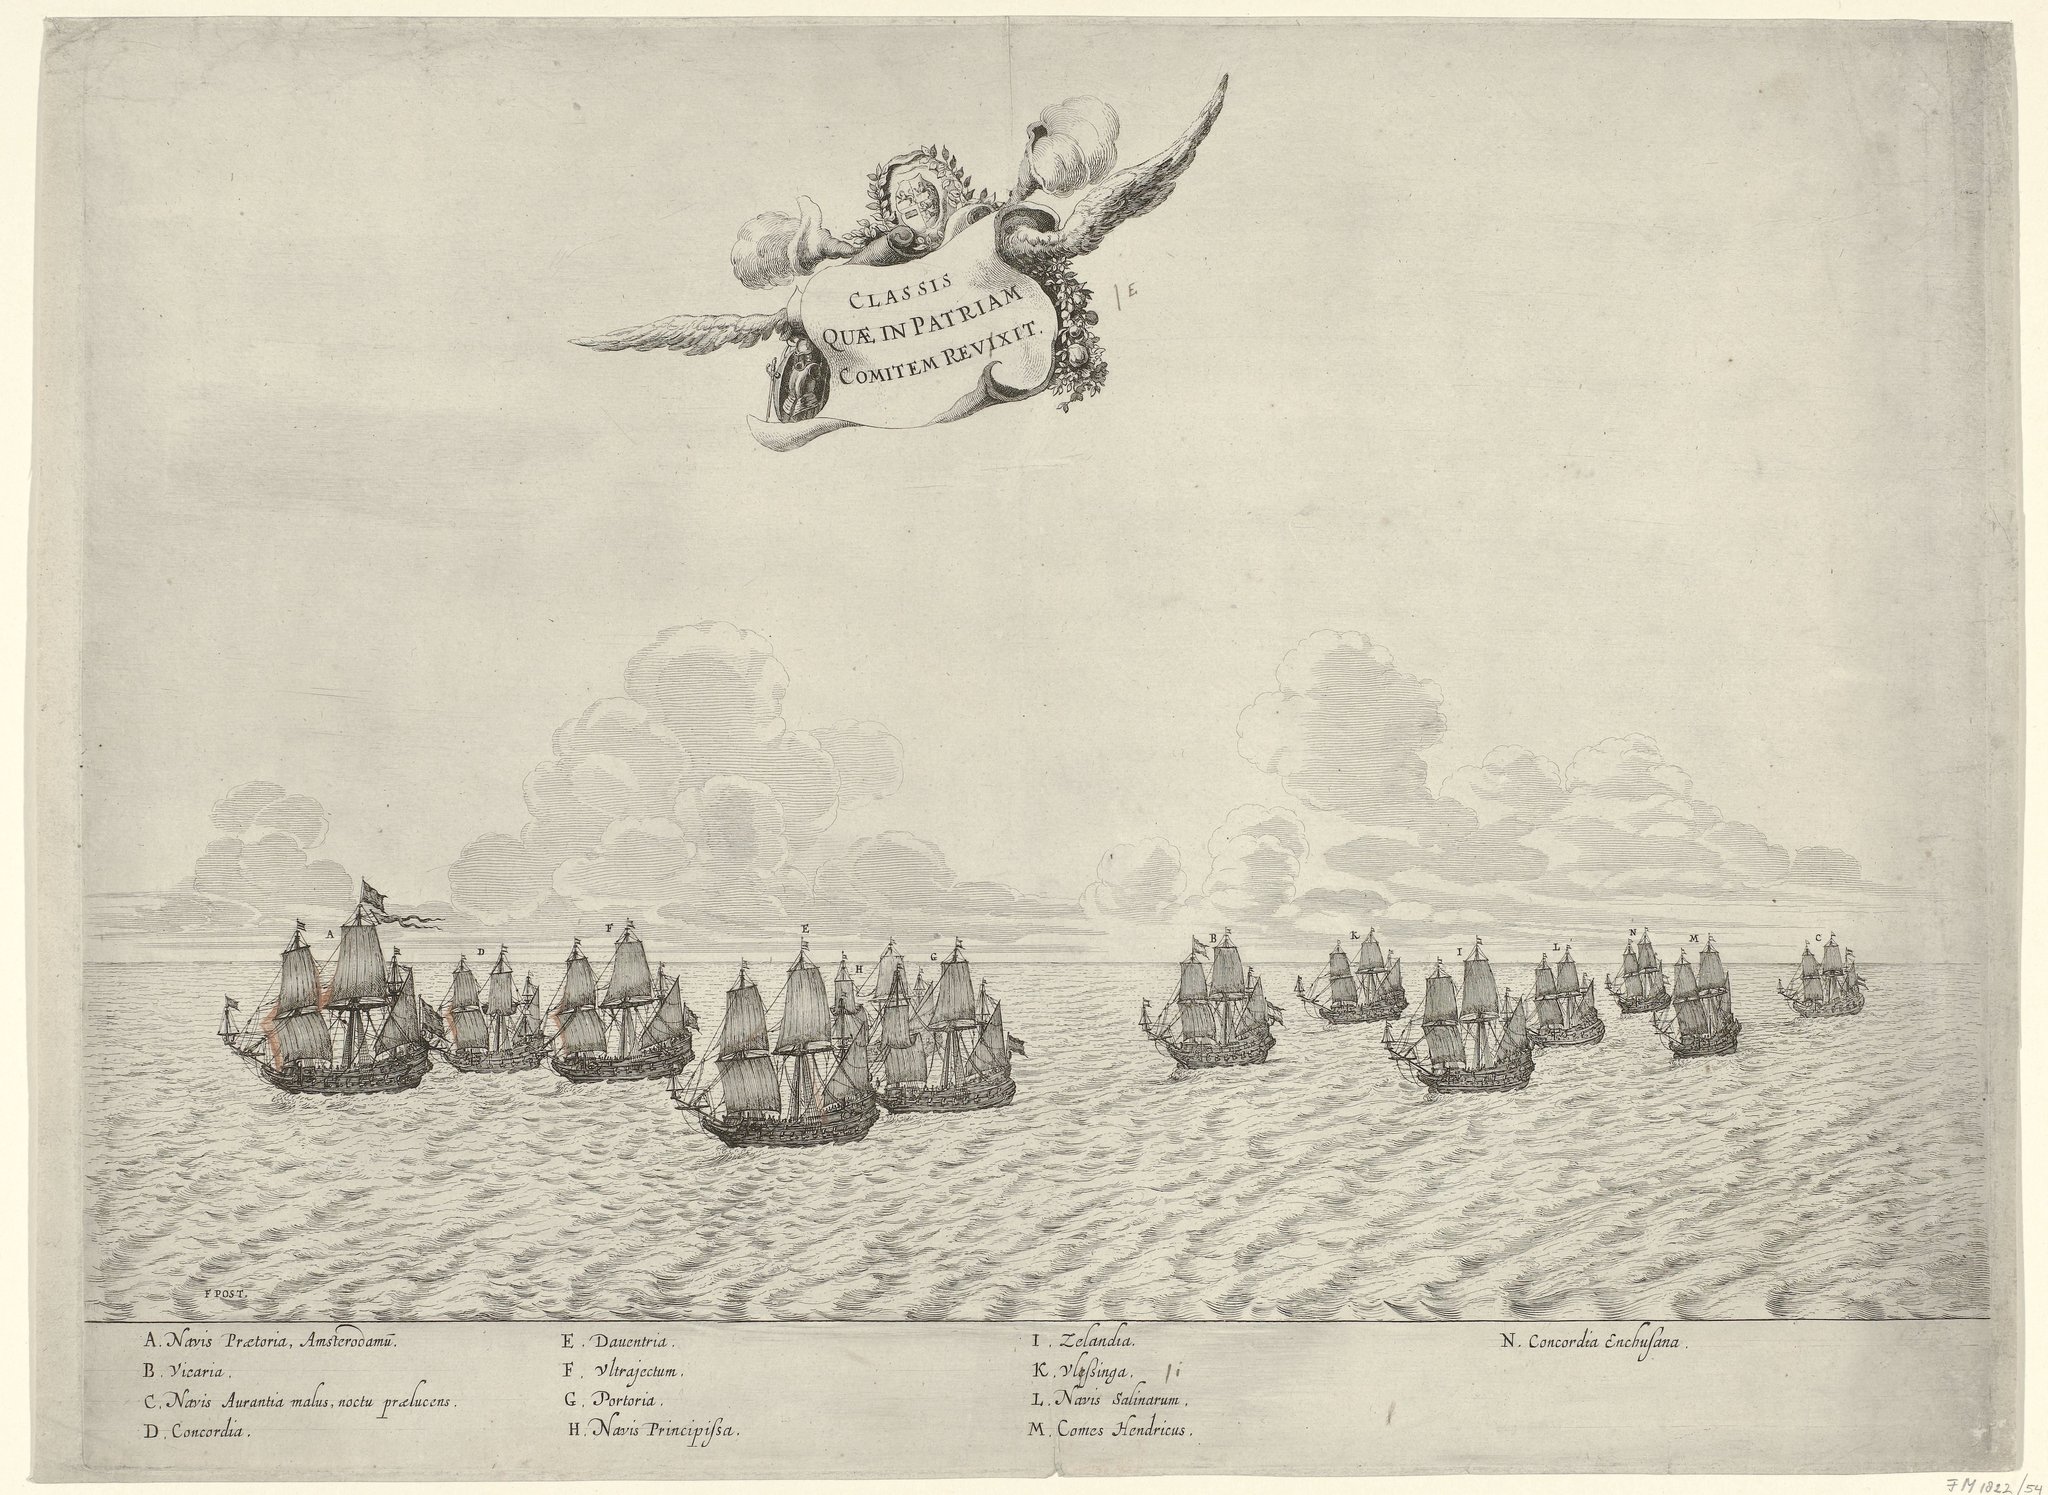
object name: print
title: Classis quae in patriam comitem revixit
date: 1645-1647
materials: chalk, ink, paper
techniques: etching, pen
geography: northern netherlands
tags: earl, johan maurits graaf van nassau-siegen, departure ~ travelling (+ propulsion of vehicle, ship, etc. by wind)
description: Terugkeer van de vloot van Johan Maurits naar de Nederlanden, mei - augustus 1644. In de lucht een gevleugelde banderol met de titel, het wapen van Johan Maurits en twee rookhoorns. In het onderschrift de verklaring van de letters A-N in het Latijn. Plaat [nr. 54] in een serie van 55 voorstellingen van de tocht naar en het verblijf in Brazilië van graaf Johan Maurits van Nassau in de jaren 1636-1644.